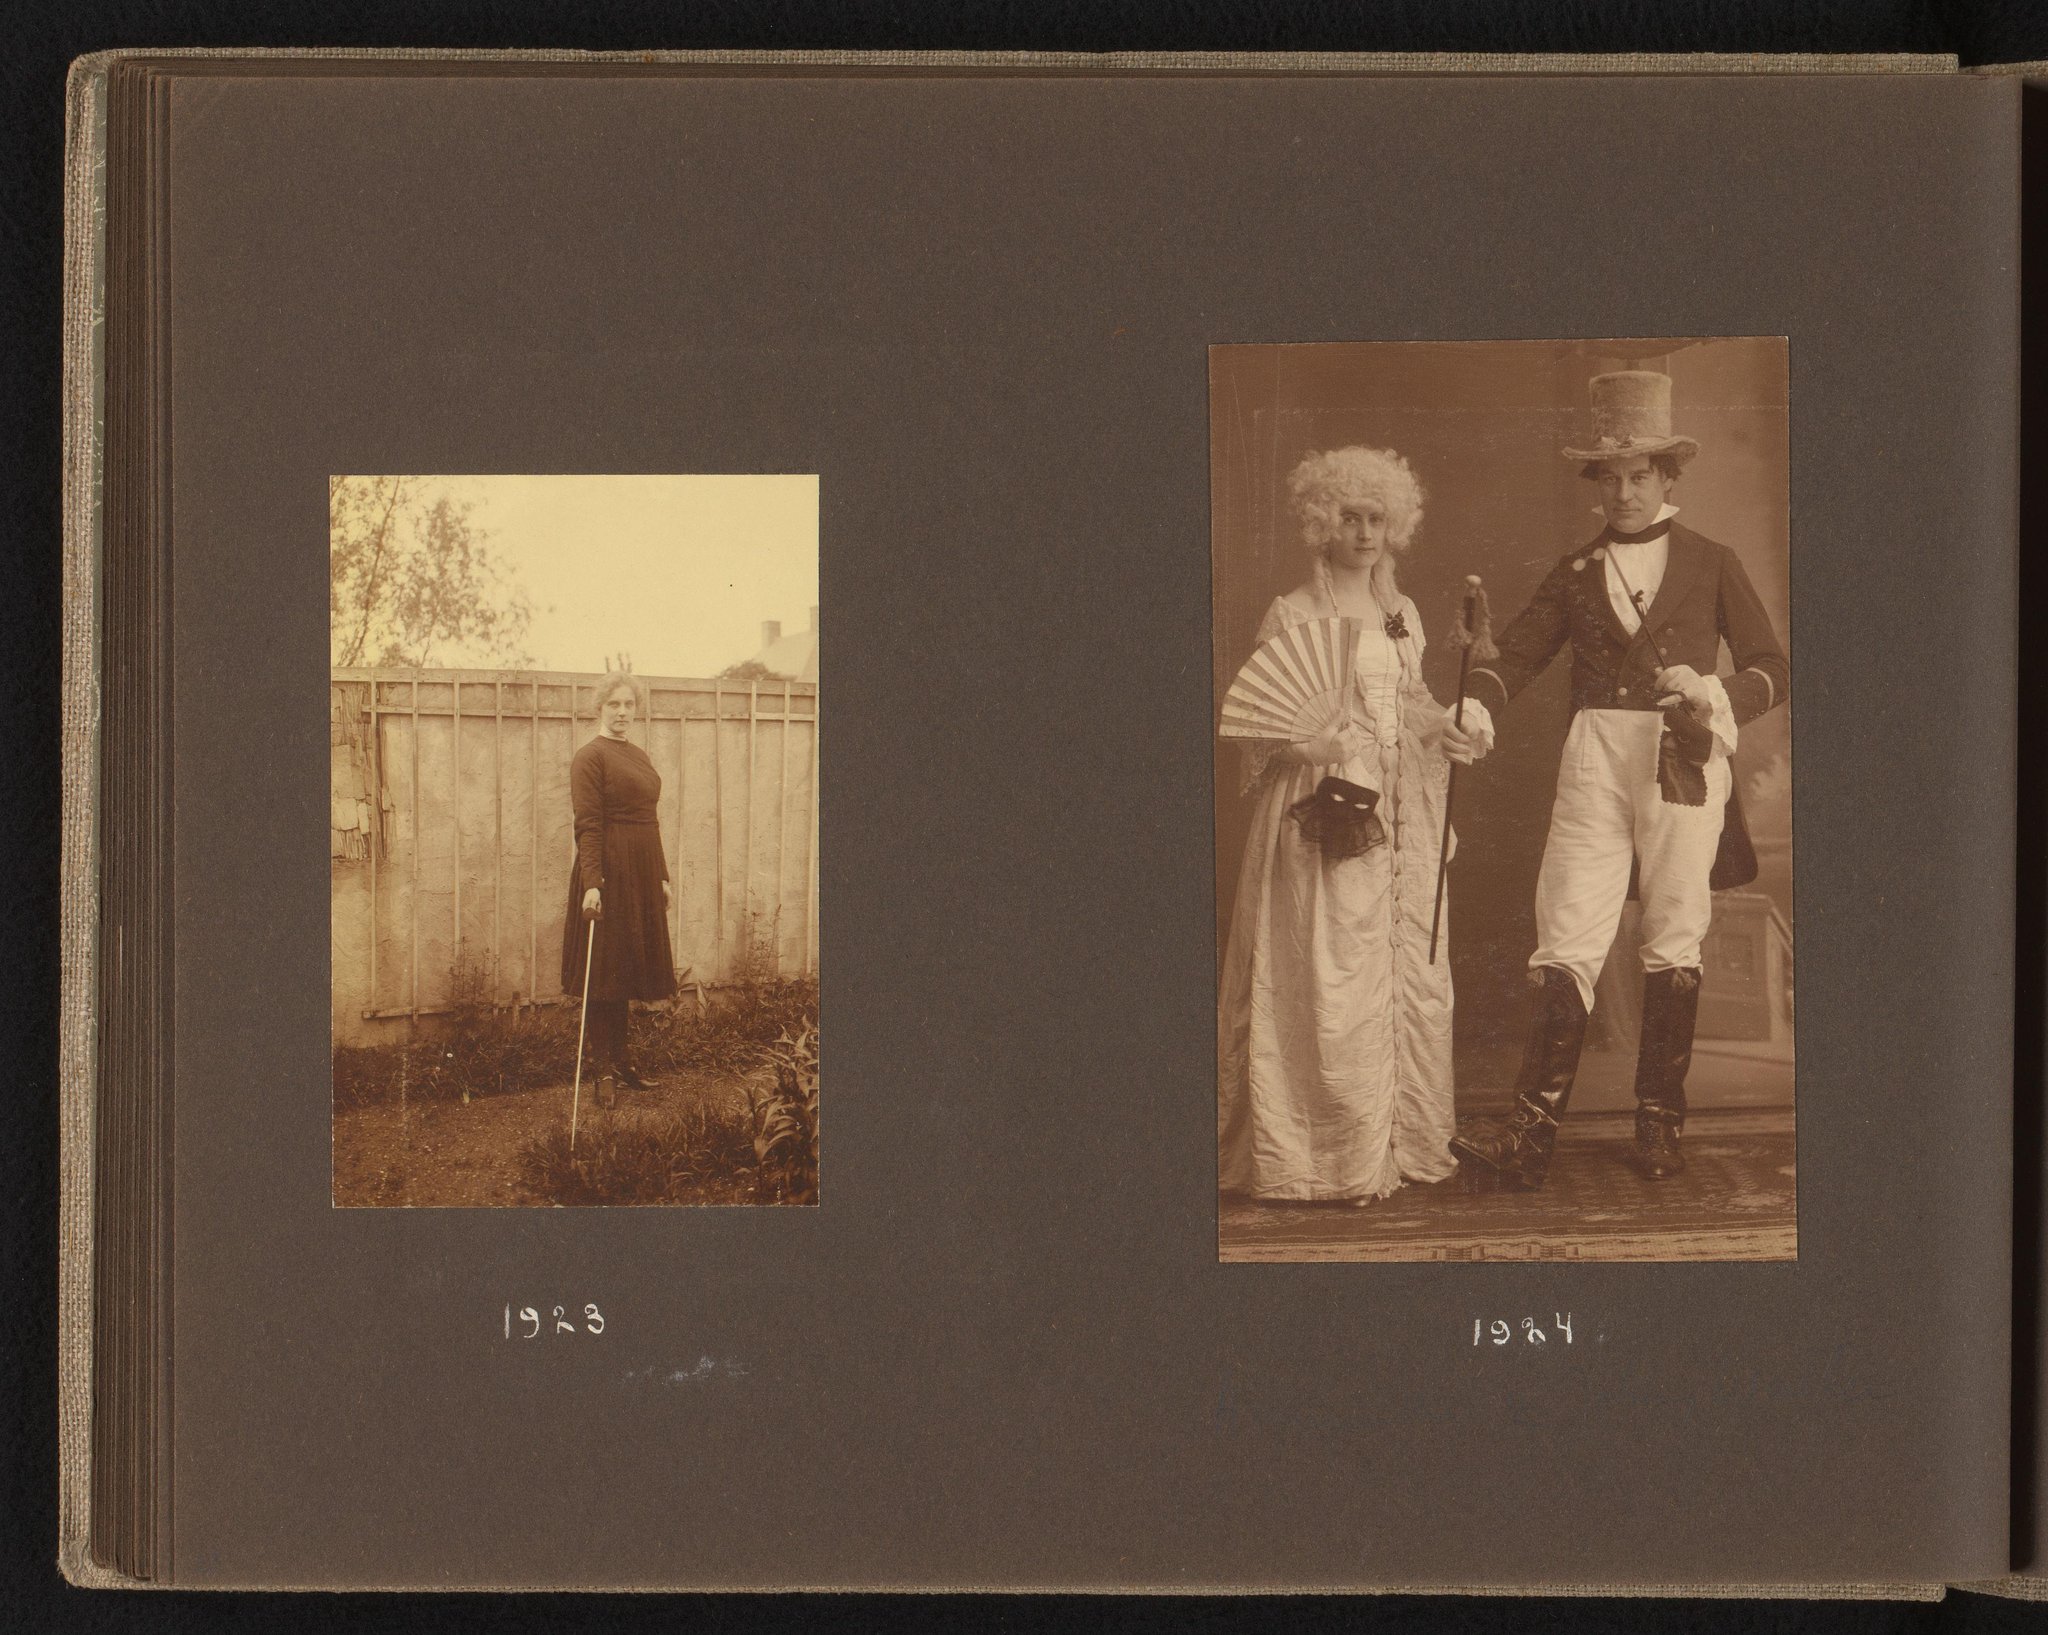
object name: album leaf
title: Portret van Johanna (Hans) de Jong in de tuin en portret van Johanna met Frederik (Frits) Stokhuyzen in historisch kostuum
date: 1923-1924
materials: paper, cardboard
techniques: collodion silver print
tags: johanna petronella lambertina stokhuyzen-de jong (hans), frederik stokhuyzen (frits), flowers, dress-up party, garden, historical persons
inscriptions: date: ‘1923’, date: ‘1924’, inscription: ‘Araminthe & Johnny Walker’